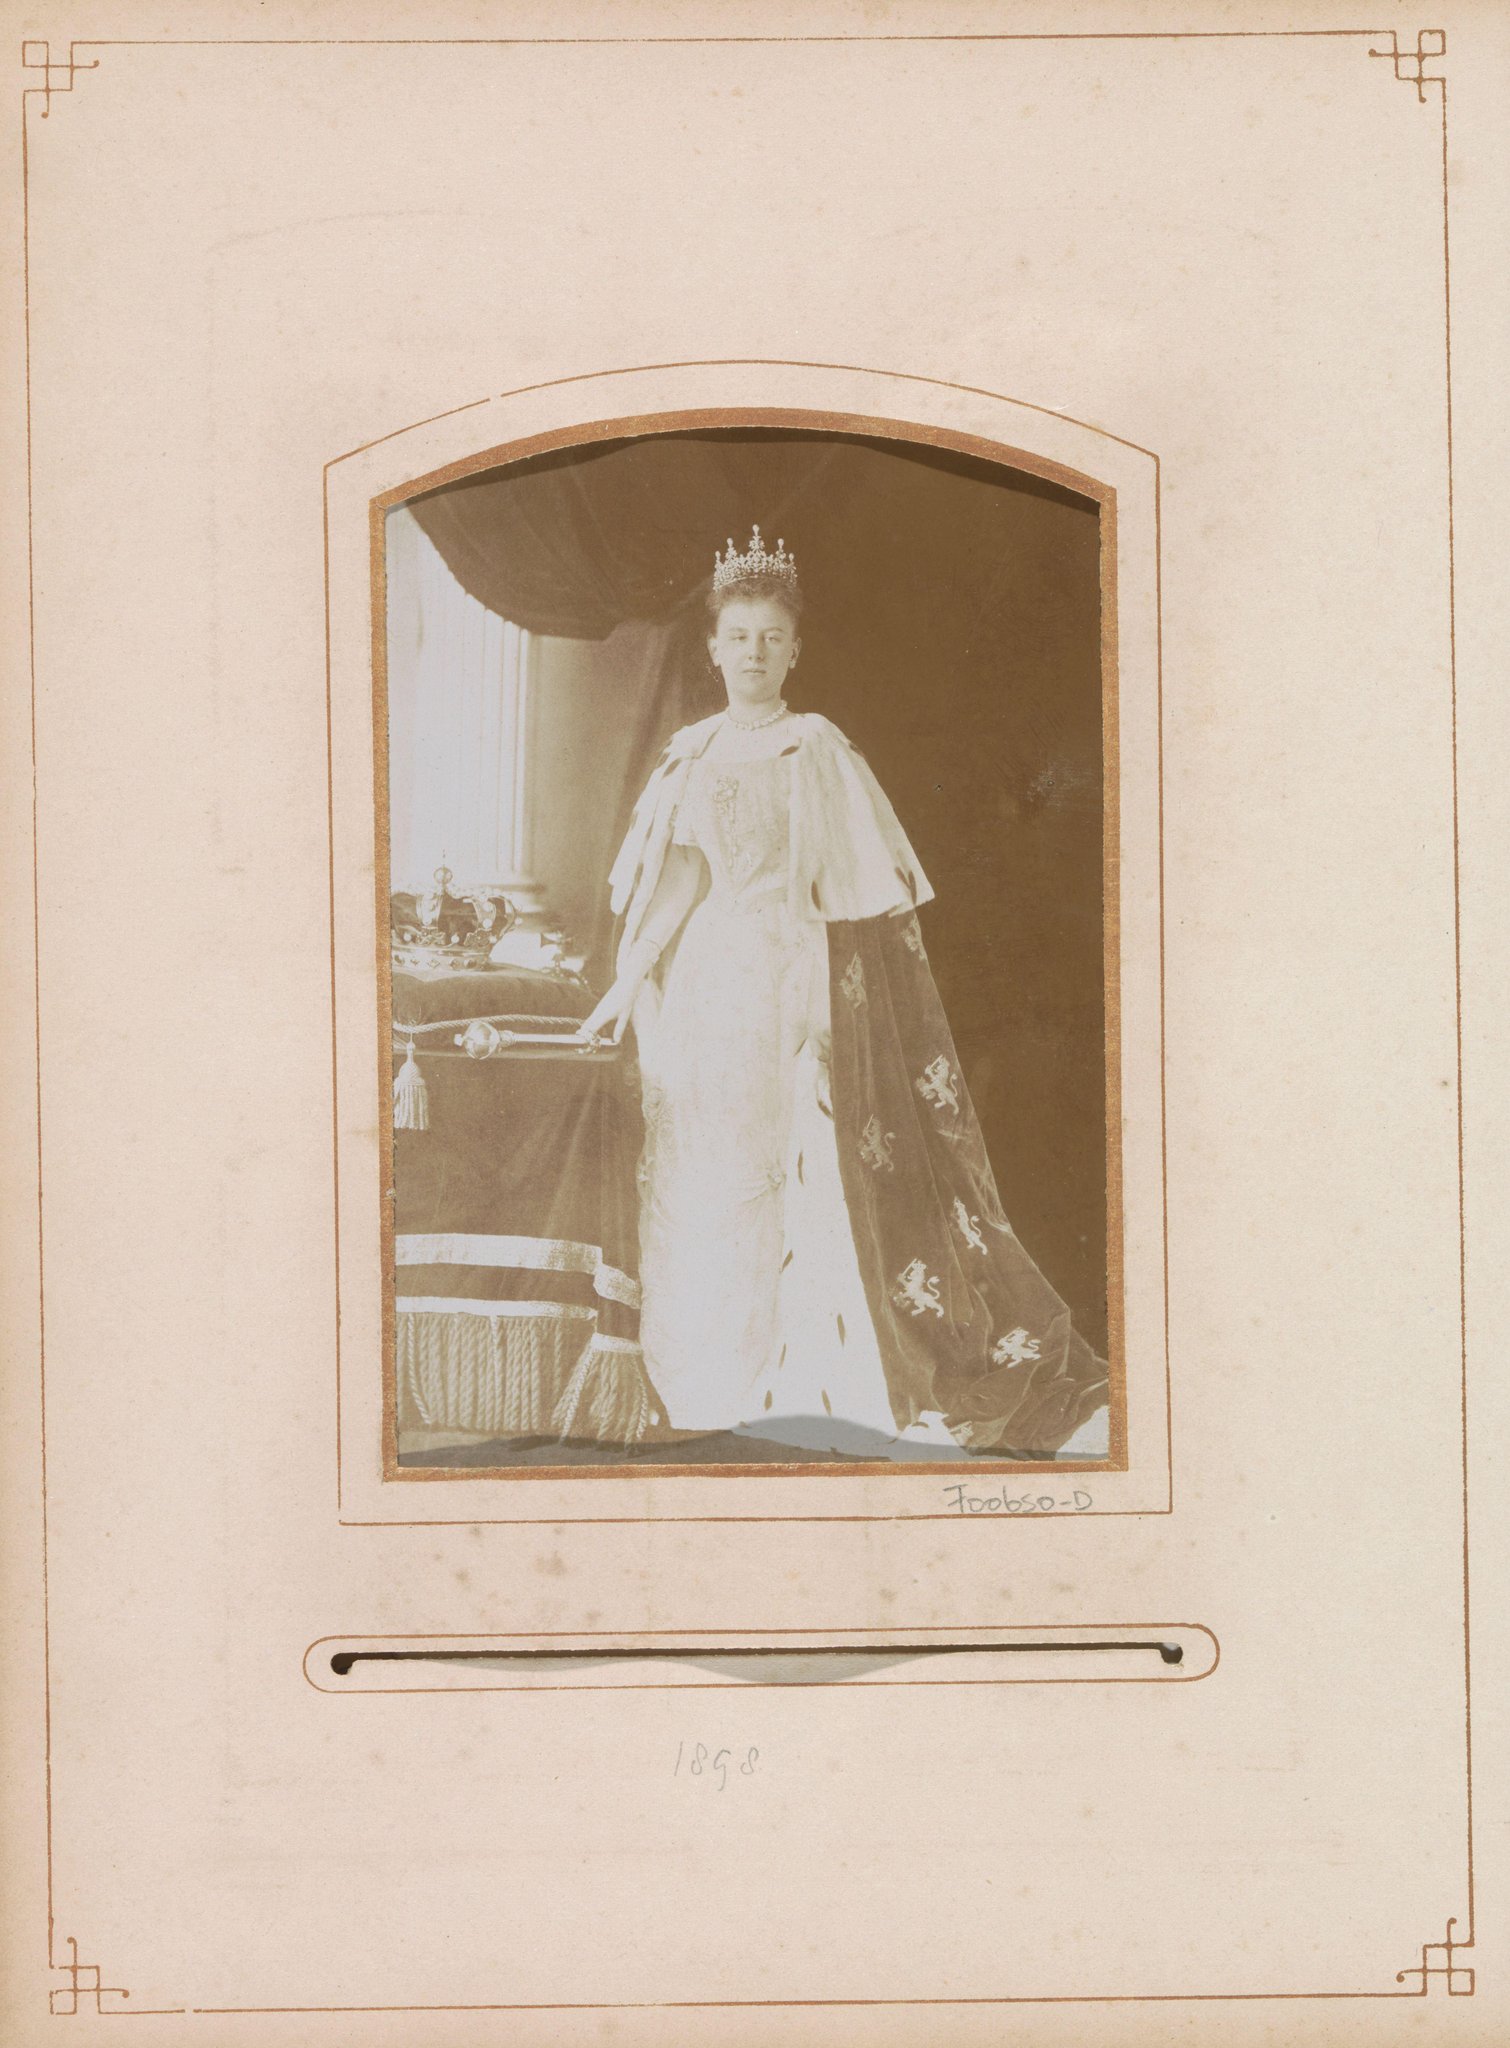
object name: cabinet photograph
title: Staatsieportret van koningin Wilhelmina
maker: Anonymous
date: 1898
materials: paper, cardboard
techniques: collodion silver print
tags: the hague, print maker, wilhelmina of the netherlands, queen, crown (symbol of sovereignty) - bb - female ruler